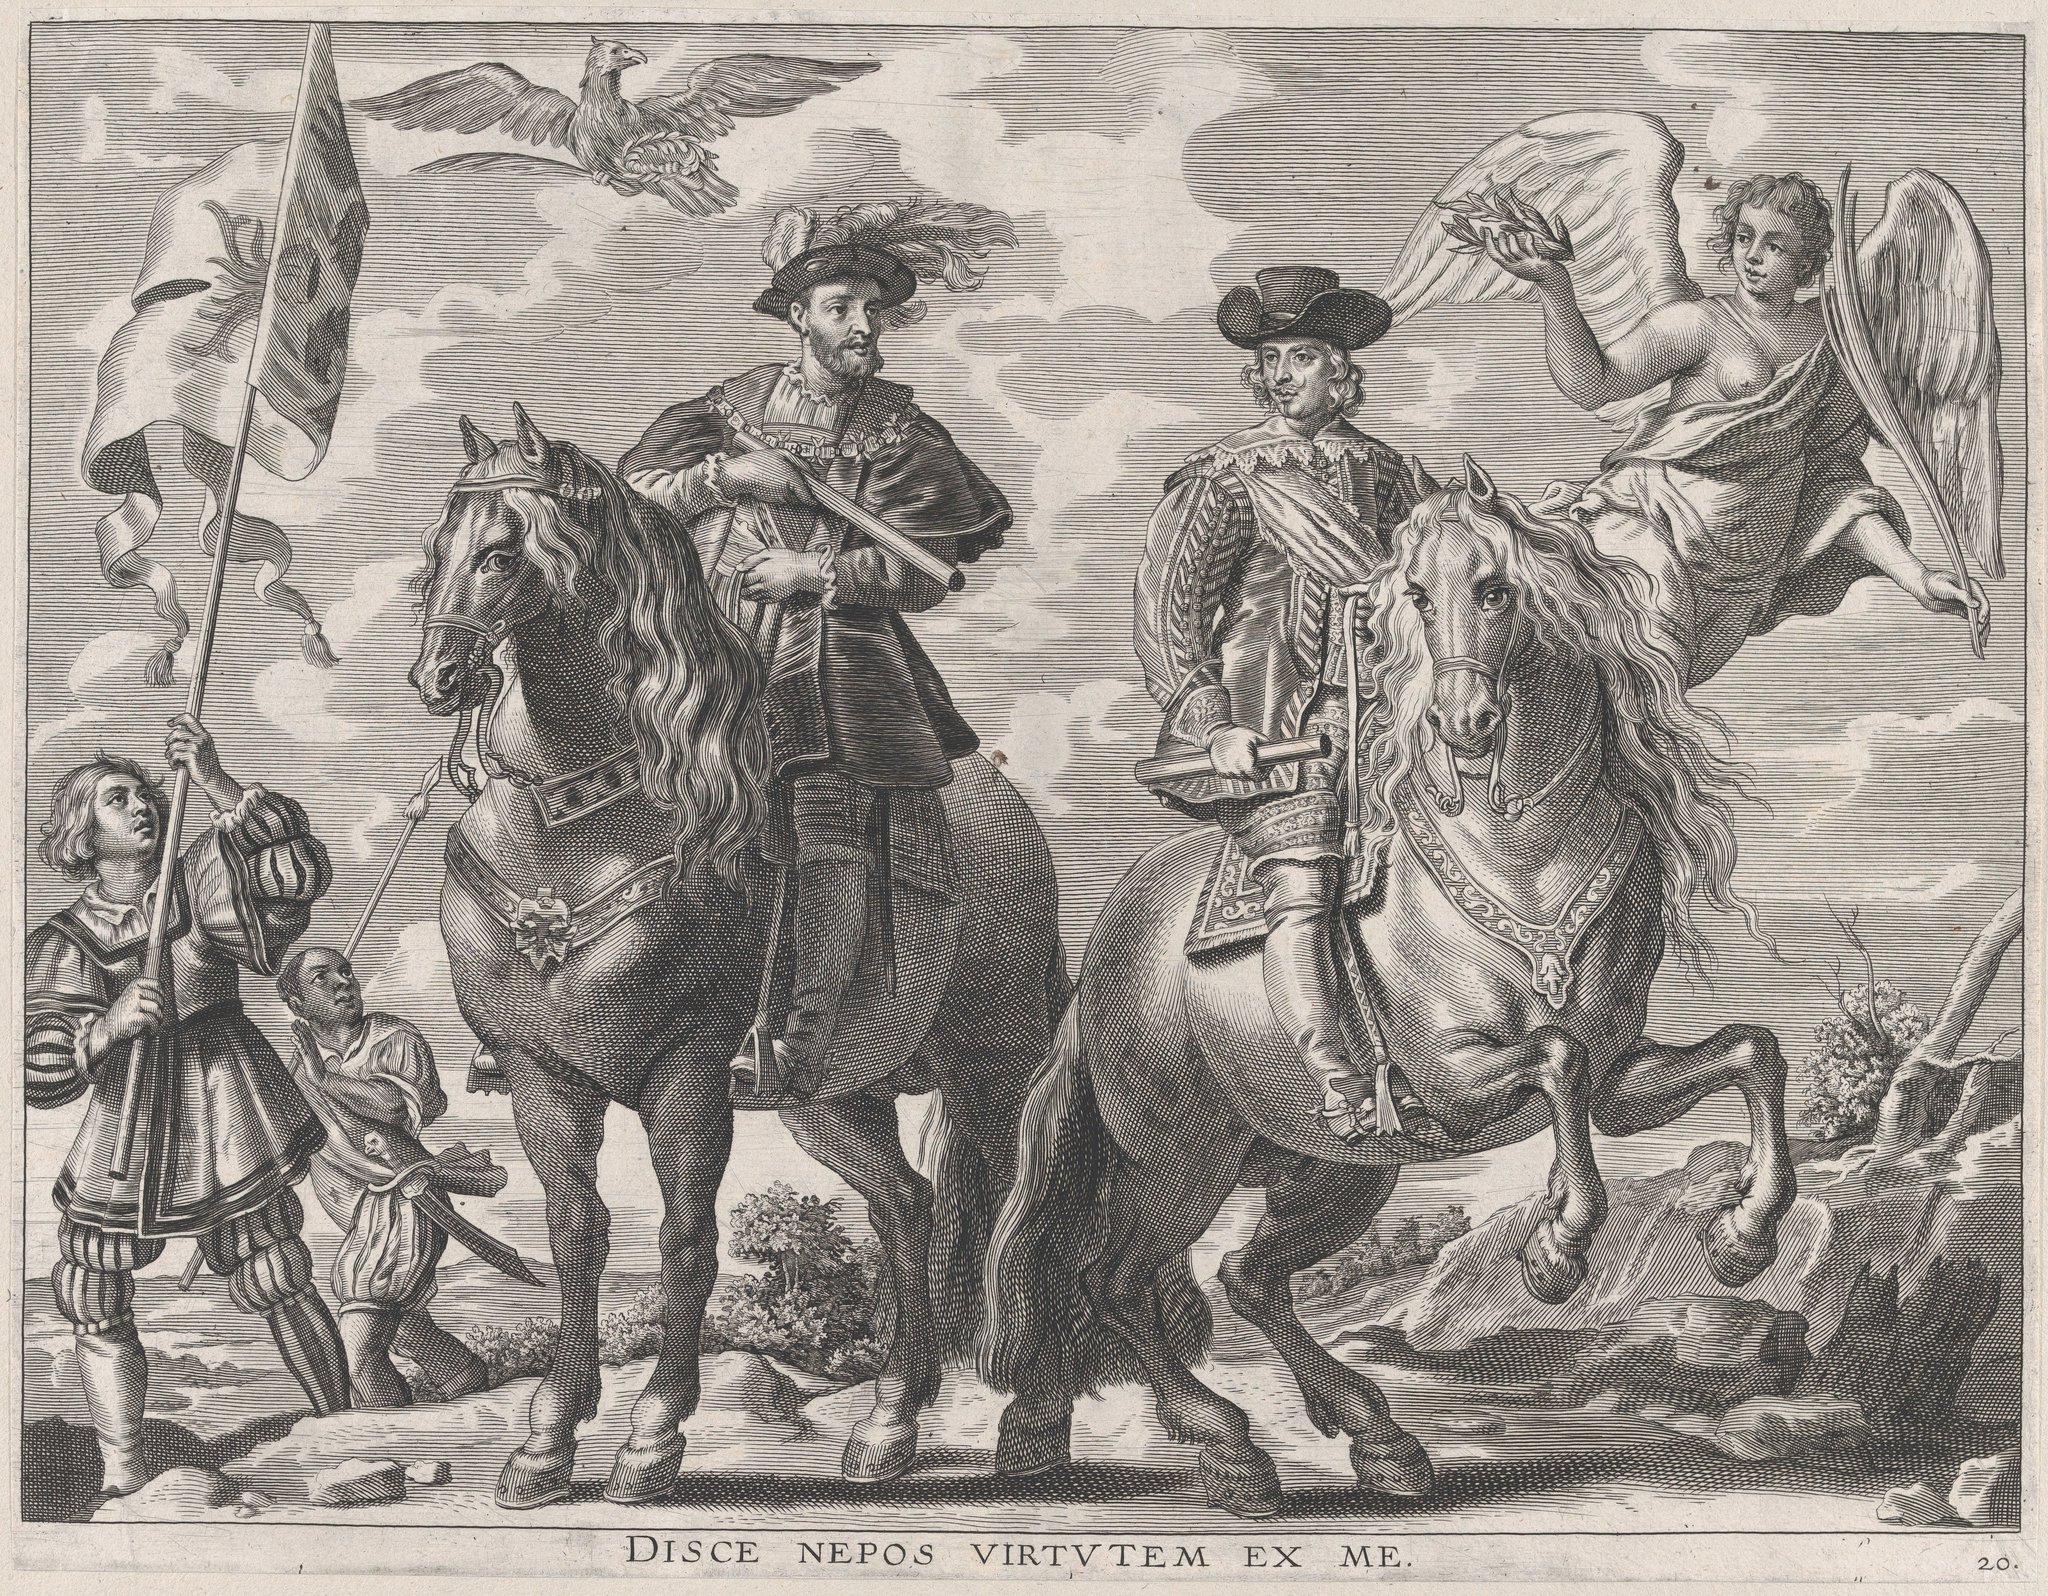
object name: print, fete, ornament architecture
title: Plate 20: Charles V and Ferdinand on Horseback; from Guillielmus Becanus's 'Serenissimi Principis Ferdinandi, Hispaniarum Infantis...'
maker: pieter de jode (ii)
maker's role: artist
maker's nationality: flemish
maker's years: 1606-1674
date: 1636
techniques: engraving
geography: antwerp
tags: eagles,men,horses,flags